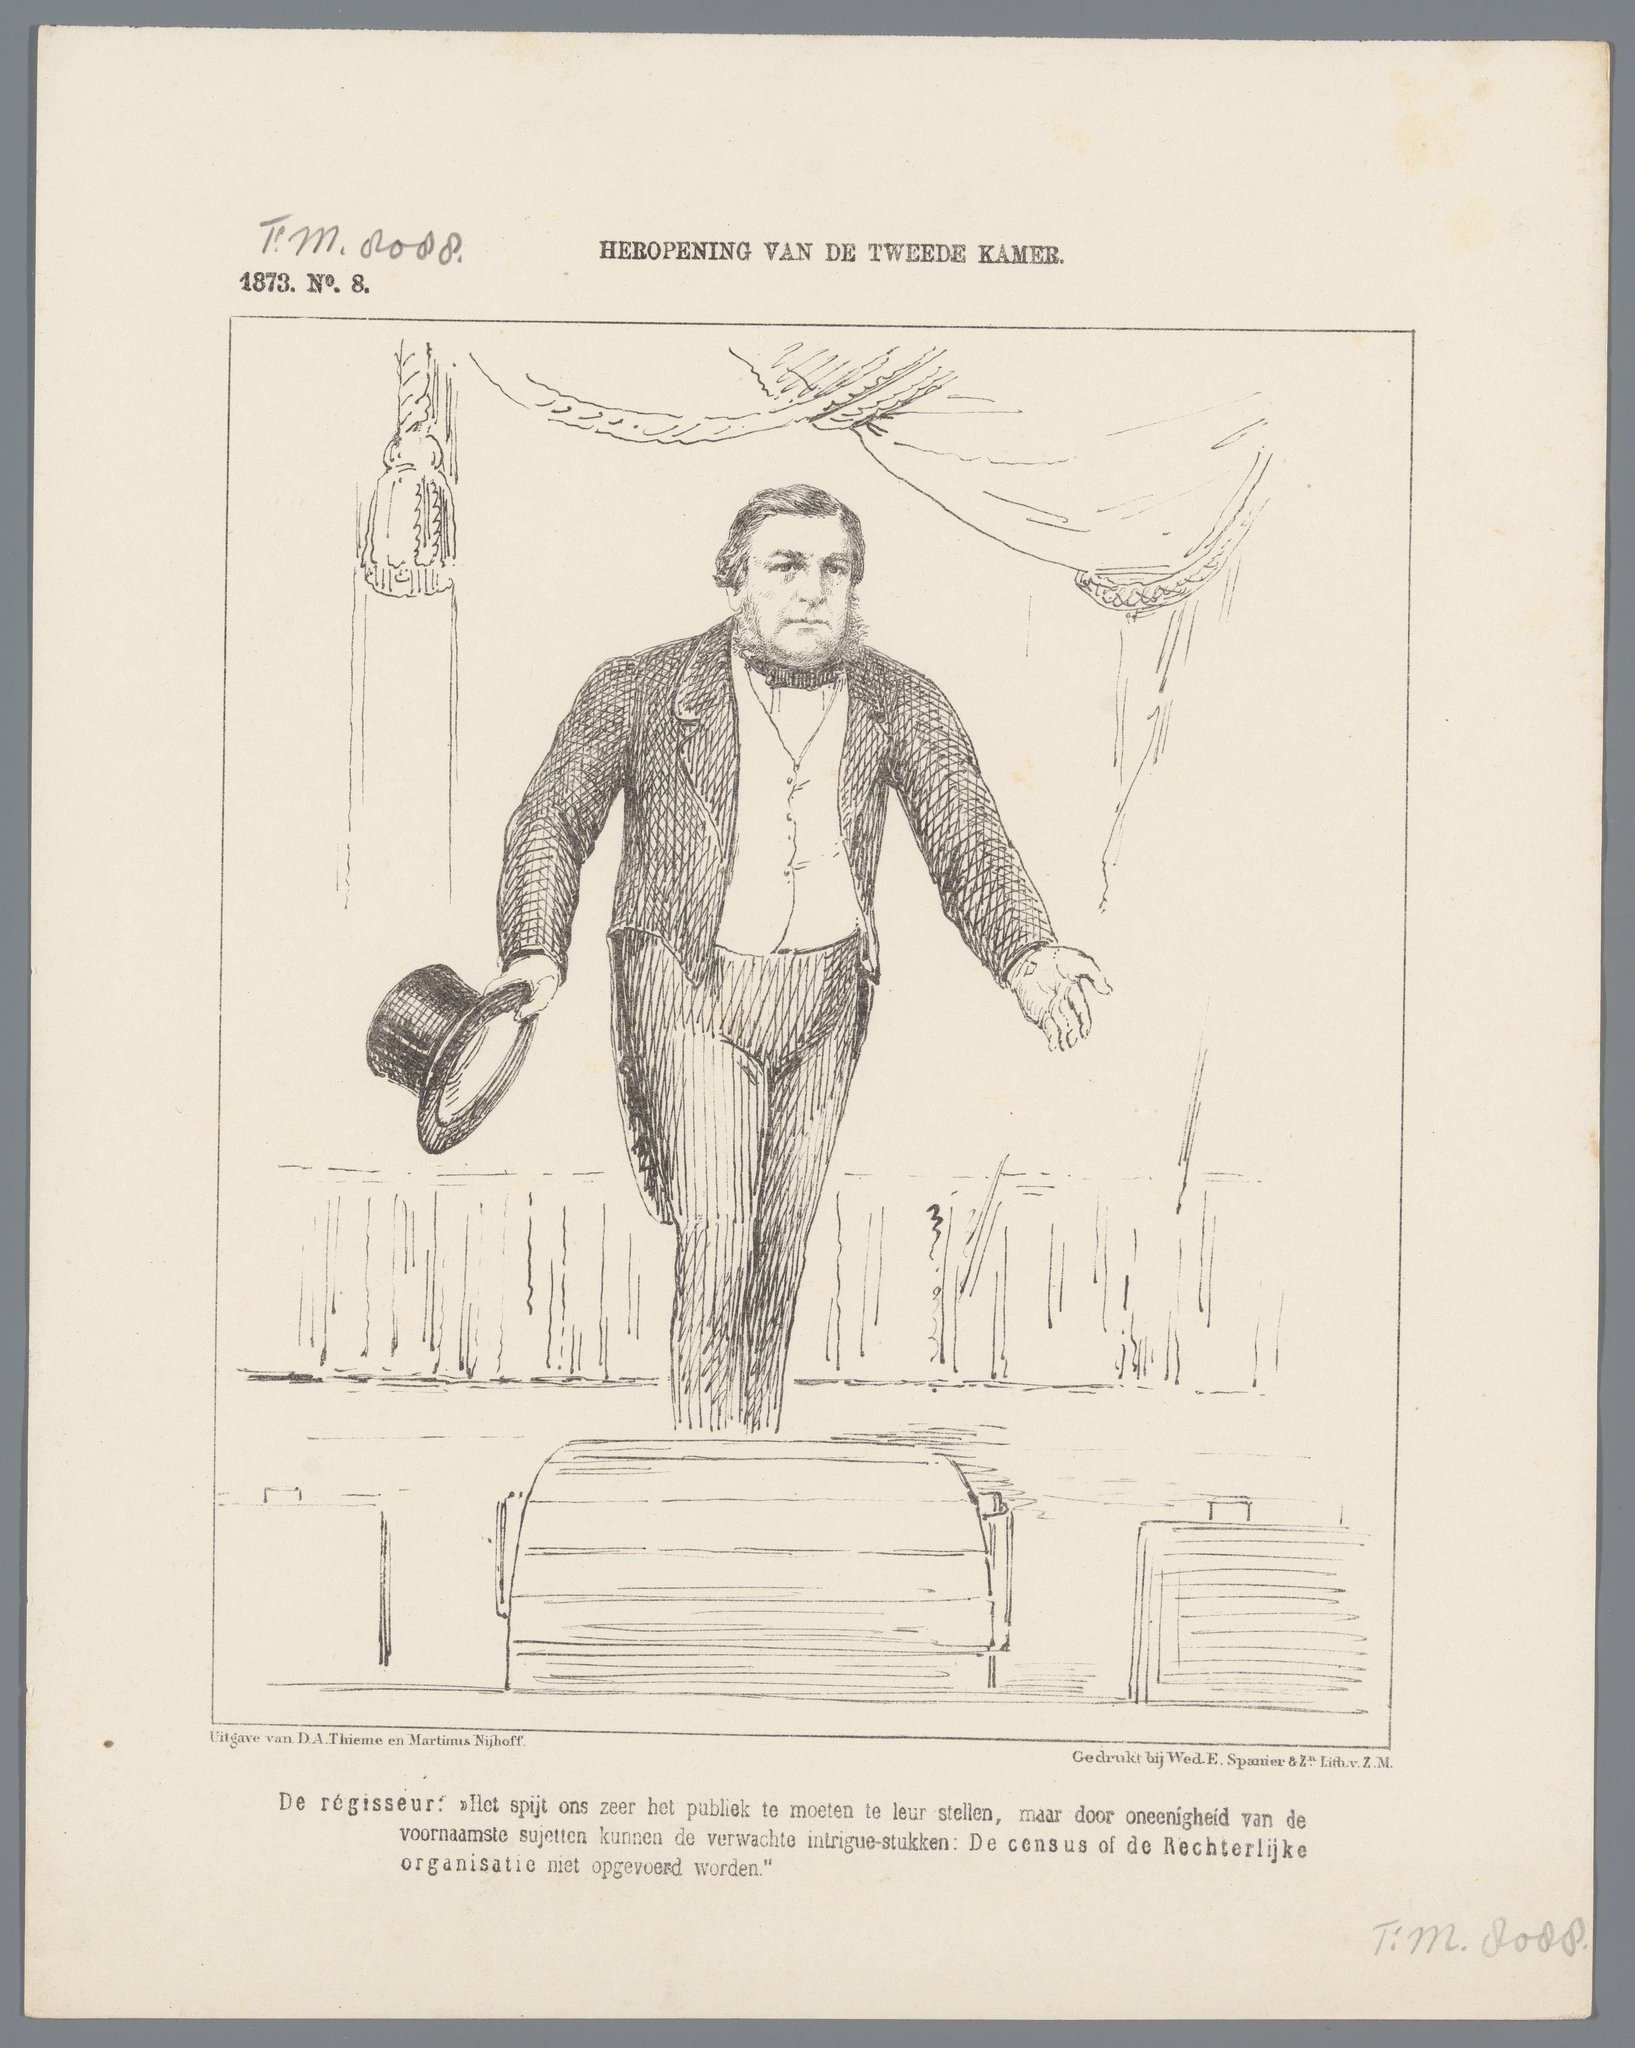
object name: cartoon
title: Heropening van de Tweede Kamer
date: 1873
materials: paper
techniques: lithograph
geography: arnhem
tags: tweede kamer der staten-generaal, voorzitter tweede kamer, willem hendrik dullert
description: Spotprent met de voorzitter van de Tweede Kamer Mr. Dullert. Op de bestaande verdeeldheid binnen de liberale partij. Plaat verschenen bij het weekblad De Nederlandsche Spectator, nr. 8, 1873.